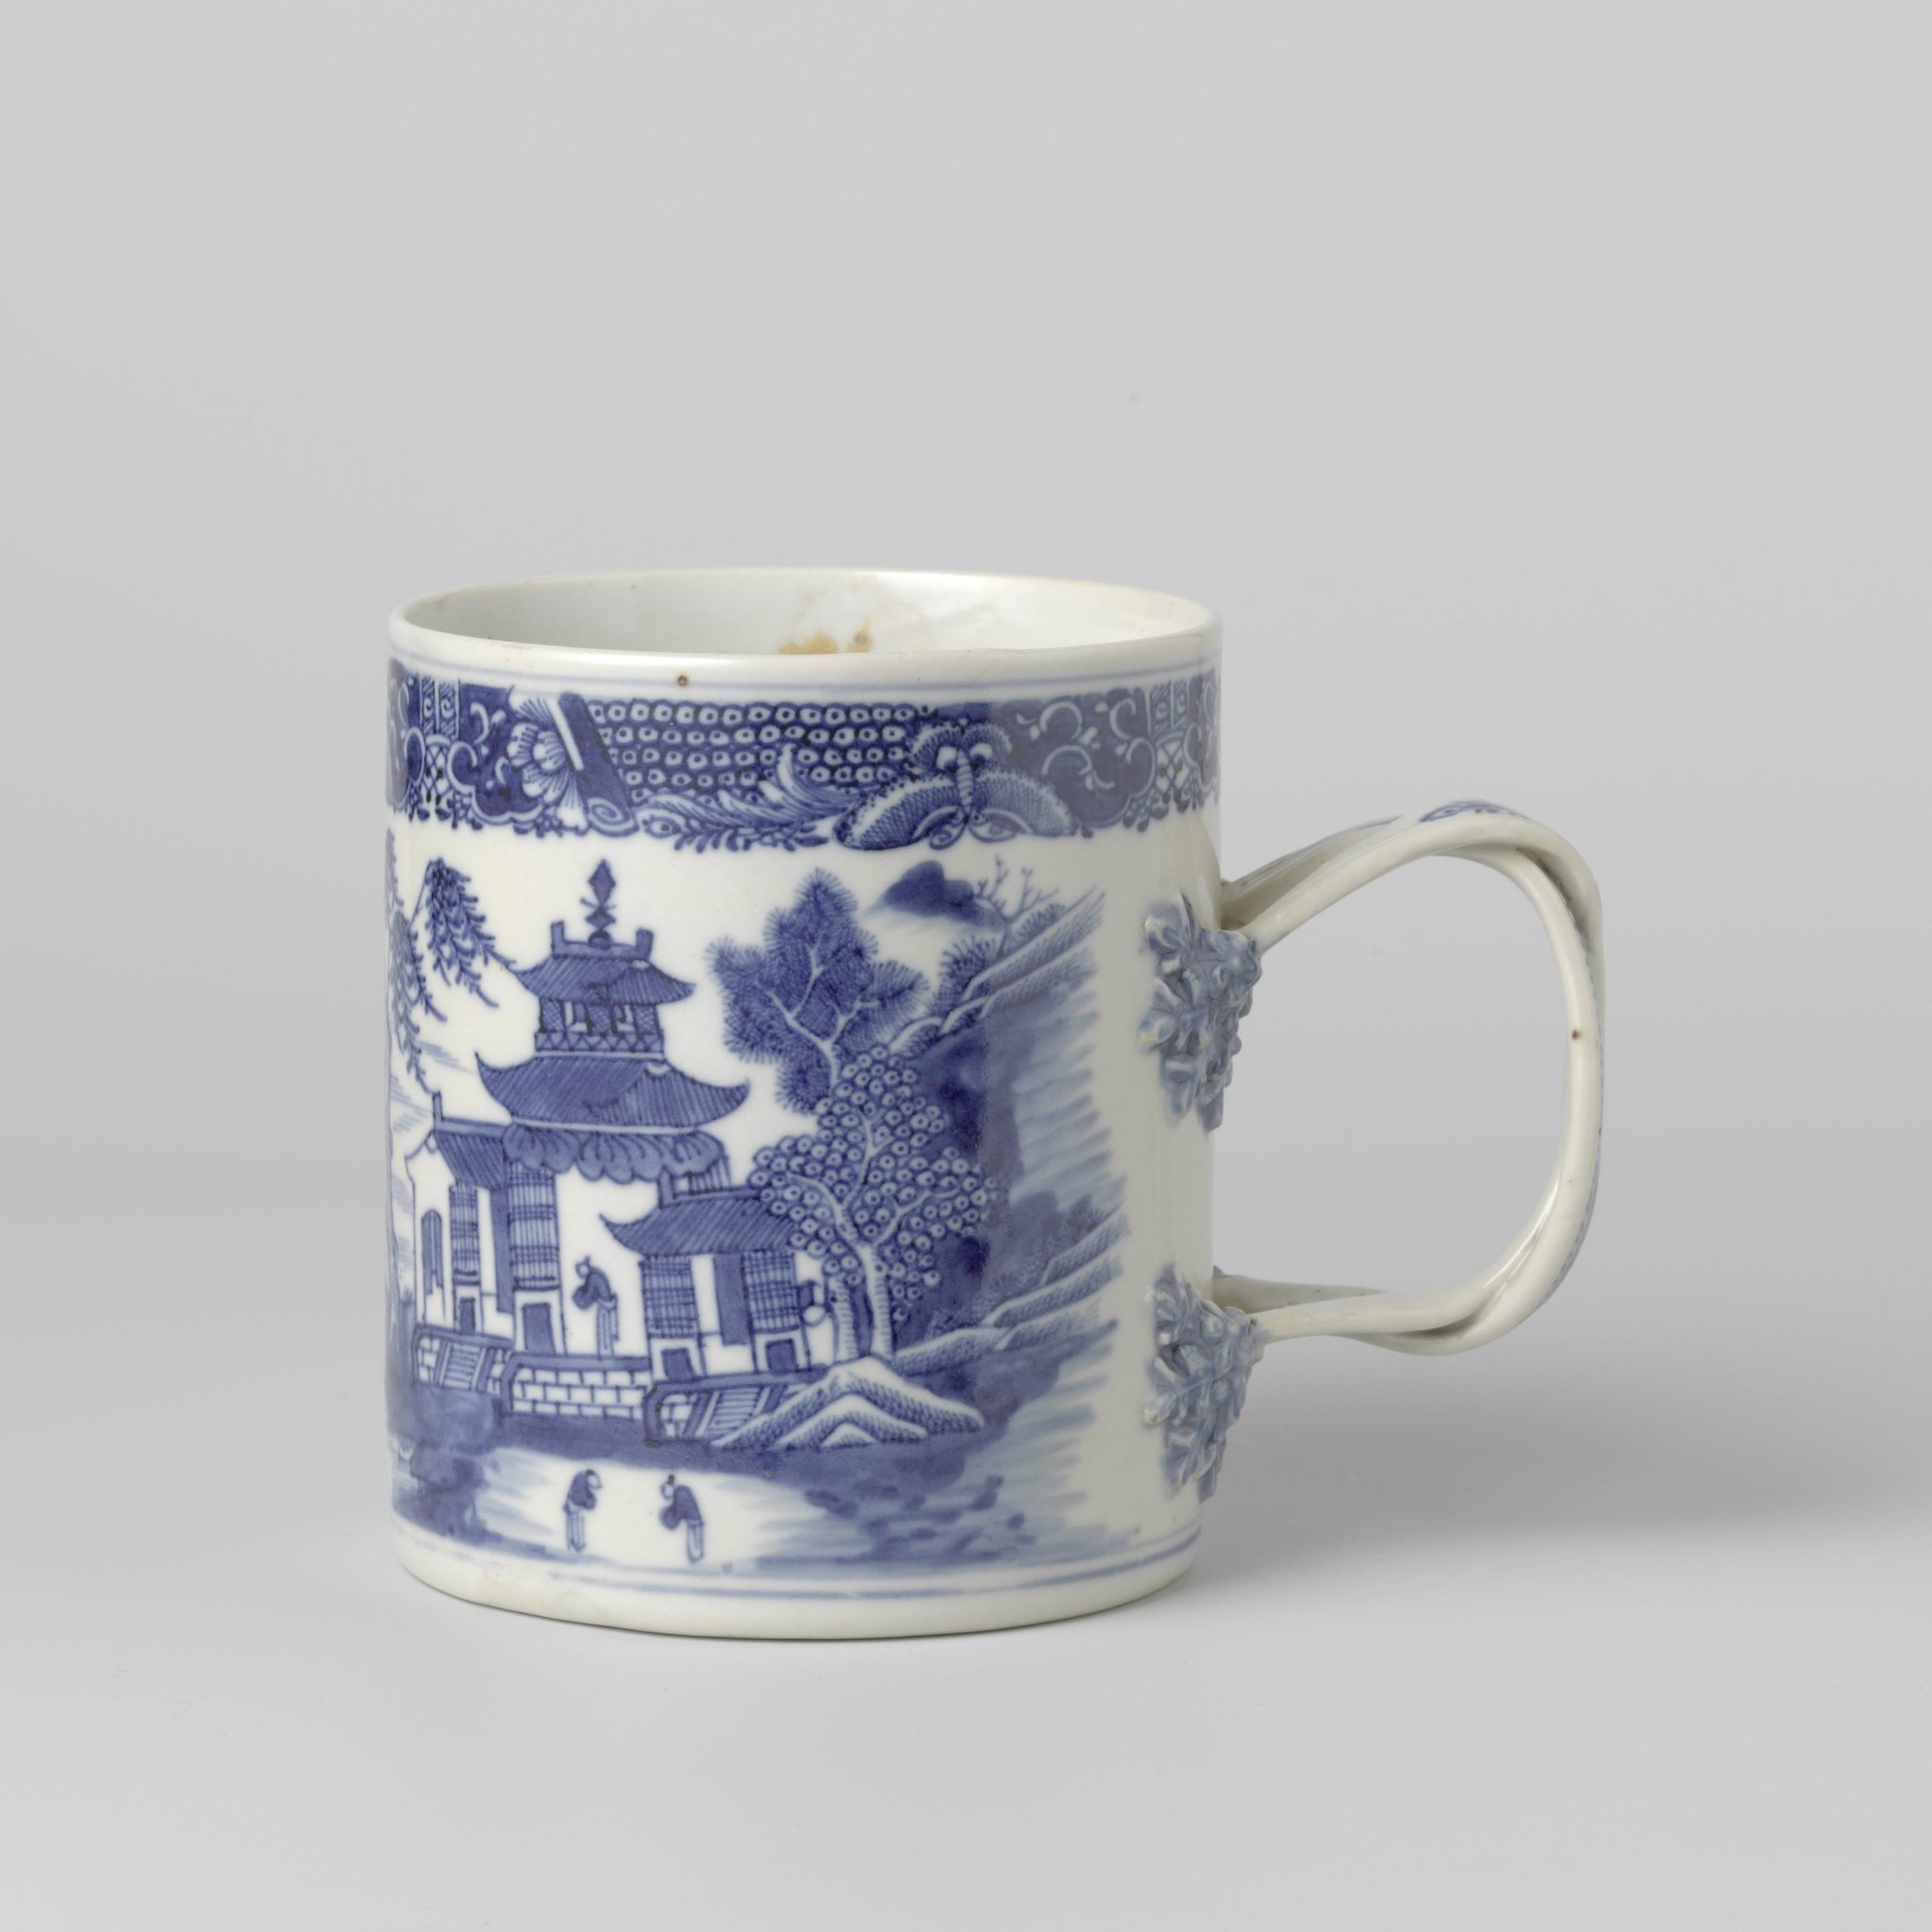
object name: cup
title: Cylindrical mug with figures in a landscape and FitzHugh-border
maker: Anonymous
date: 1780-1800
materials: cobalt, glaze, paint, porcelain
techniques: firing, forming, turning, vitrification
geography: china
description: Cilindrische beker met een C-vormig oor dat bestaat uit twee ineengedraaide strengen; een vlakke, ongeglazuurde bodem. Beschilderd in onderglazuur blauw met een waterlandschapje met wilg en paviljoen. Rond de rand een Fitzhugh-band.